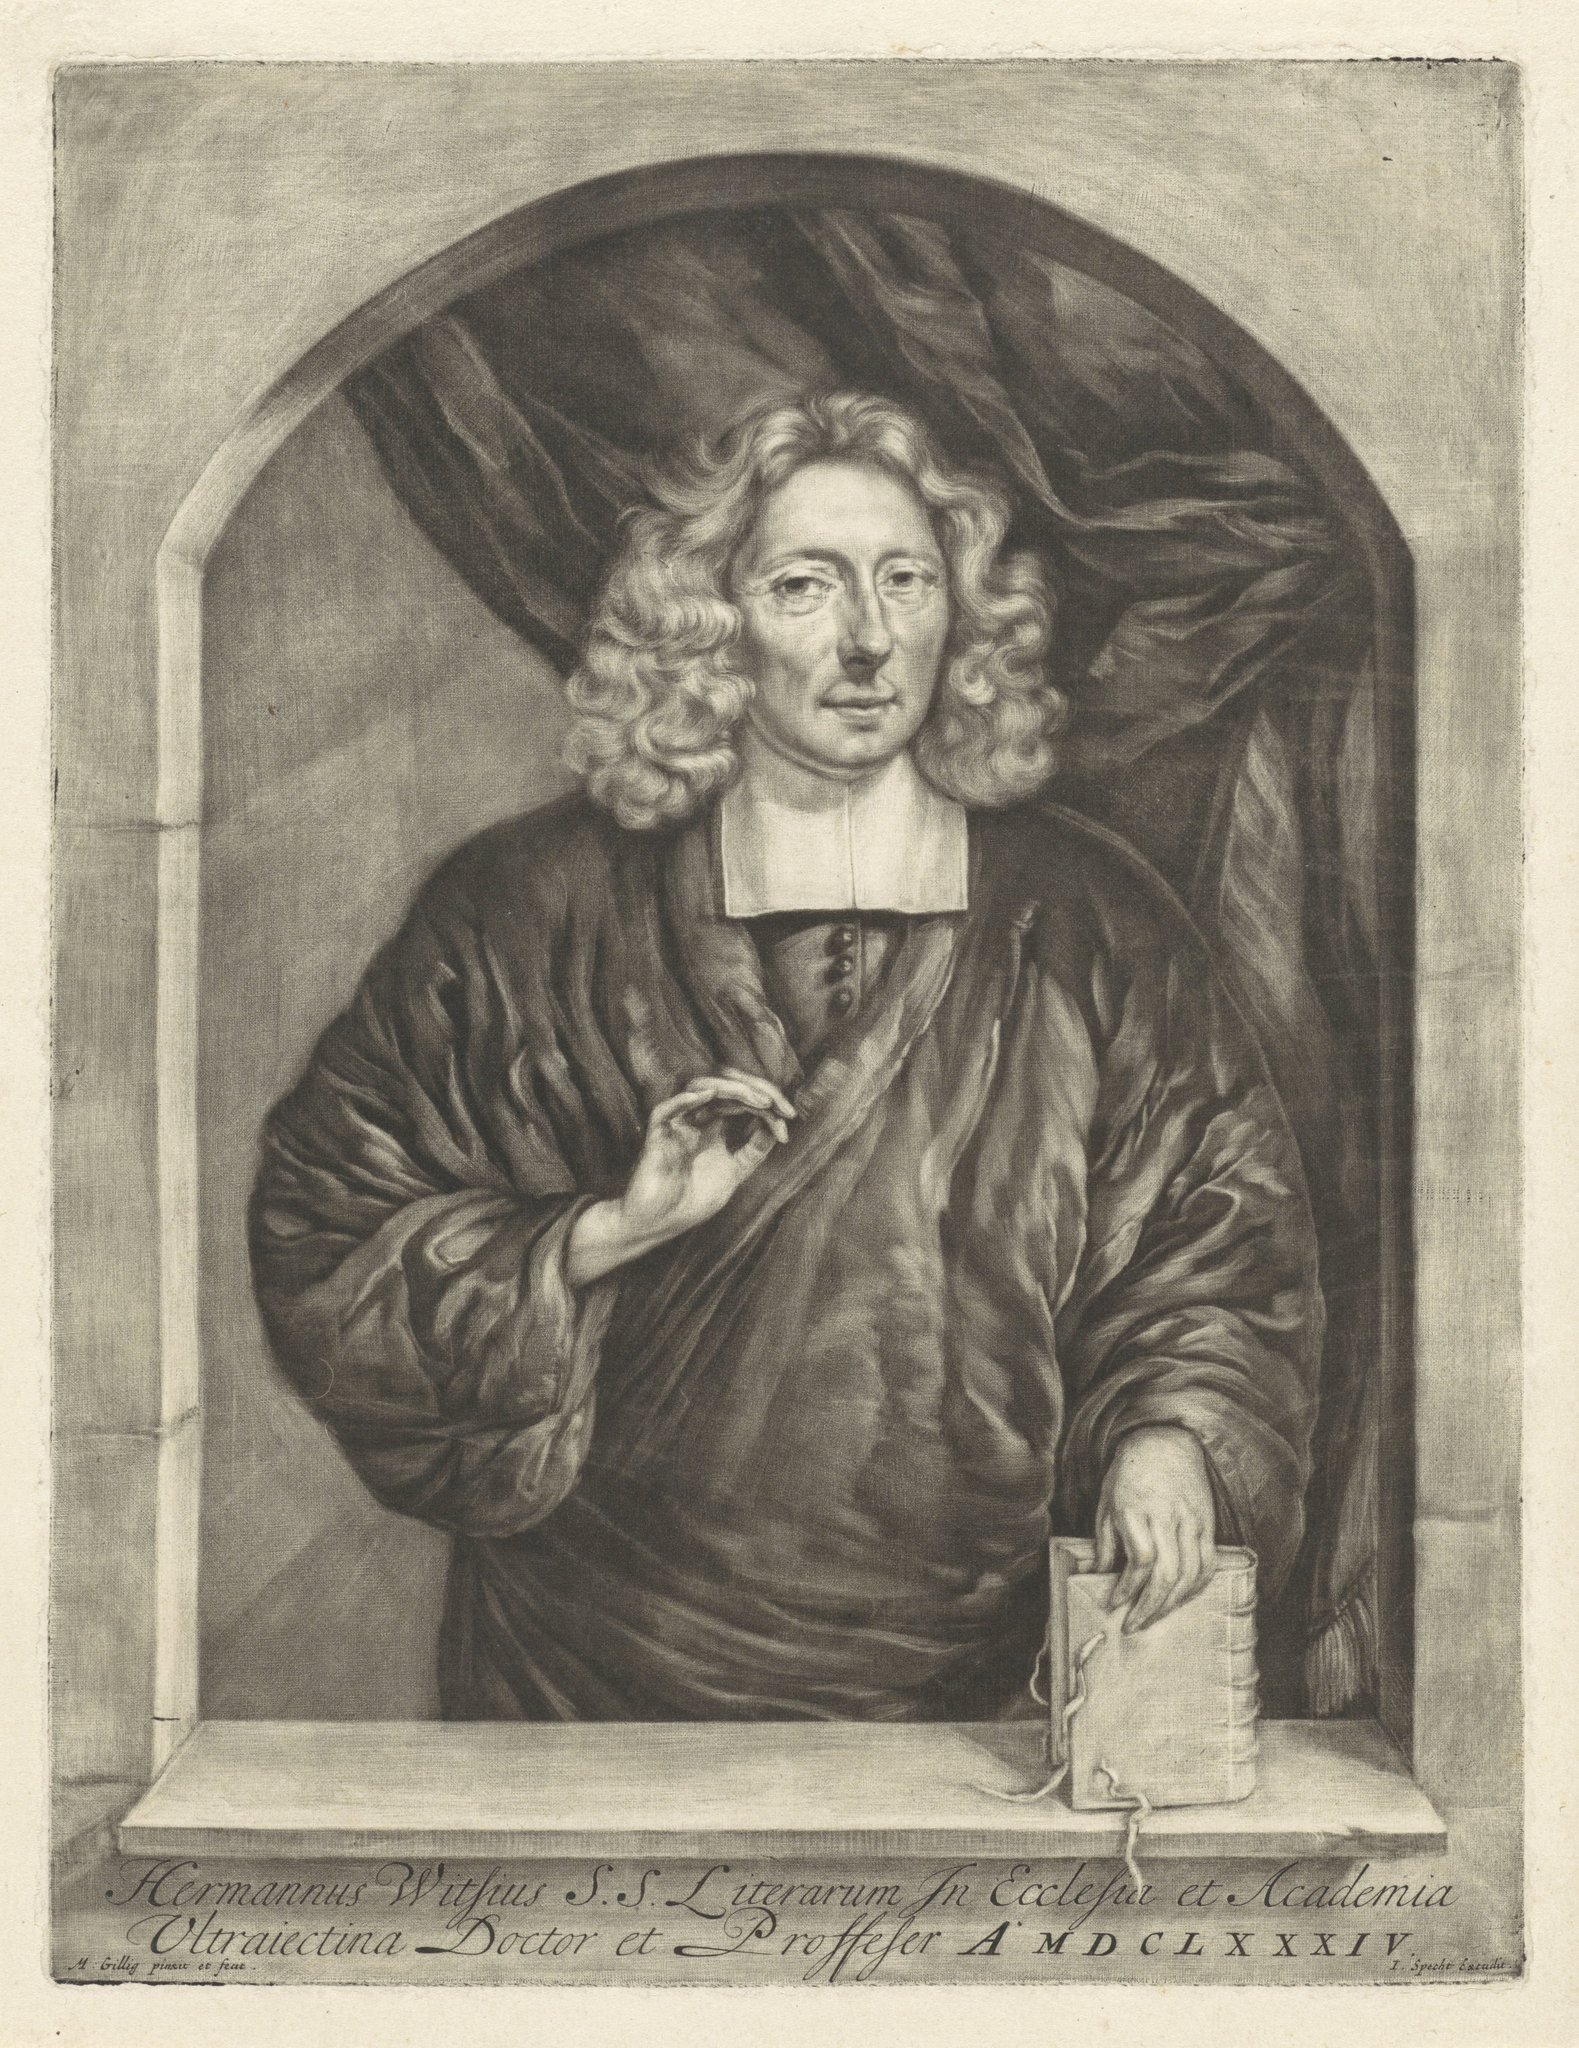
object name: print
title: Portret van Herman Witsius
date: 1684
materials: paper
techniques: engraving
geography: utrecht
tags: leiden, herman witsius, book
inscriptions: collector's mark: Lugt 2228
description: Herman Witsius, predikant en hoogleraar theologie te Franeker, Utrecht en Leiden.